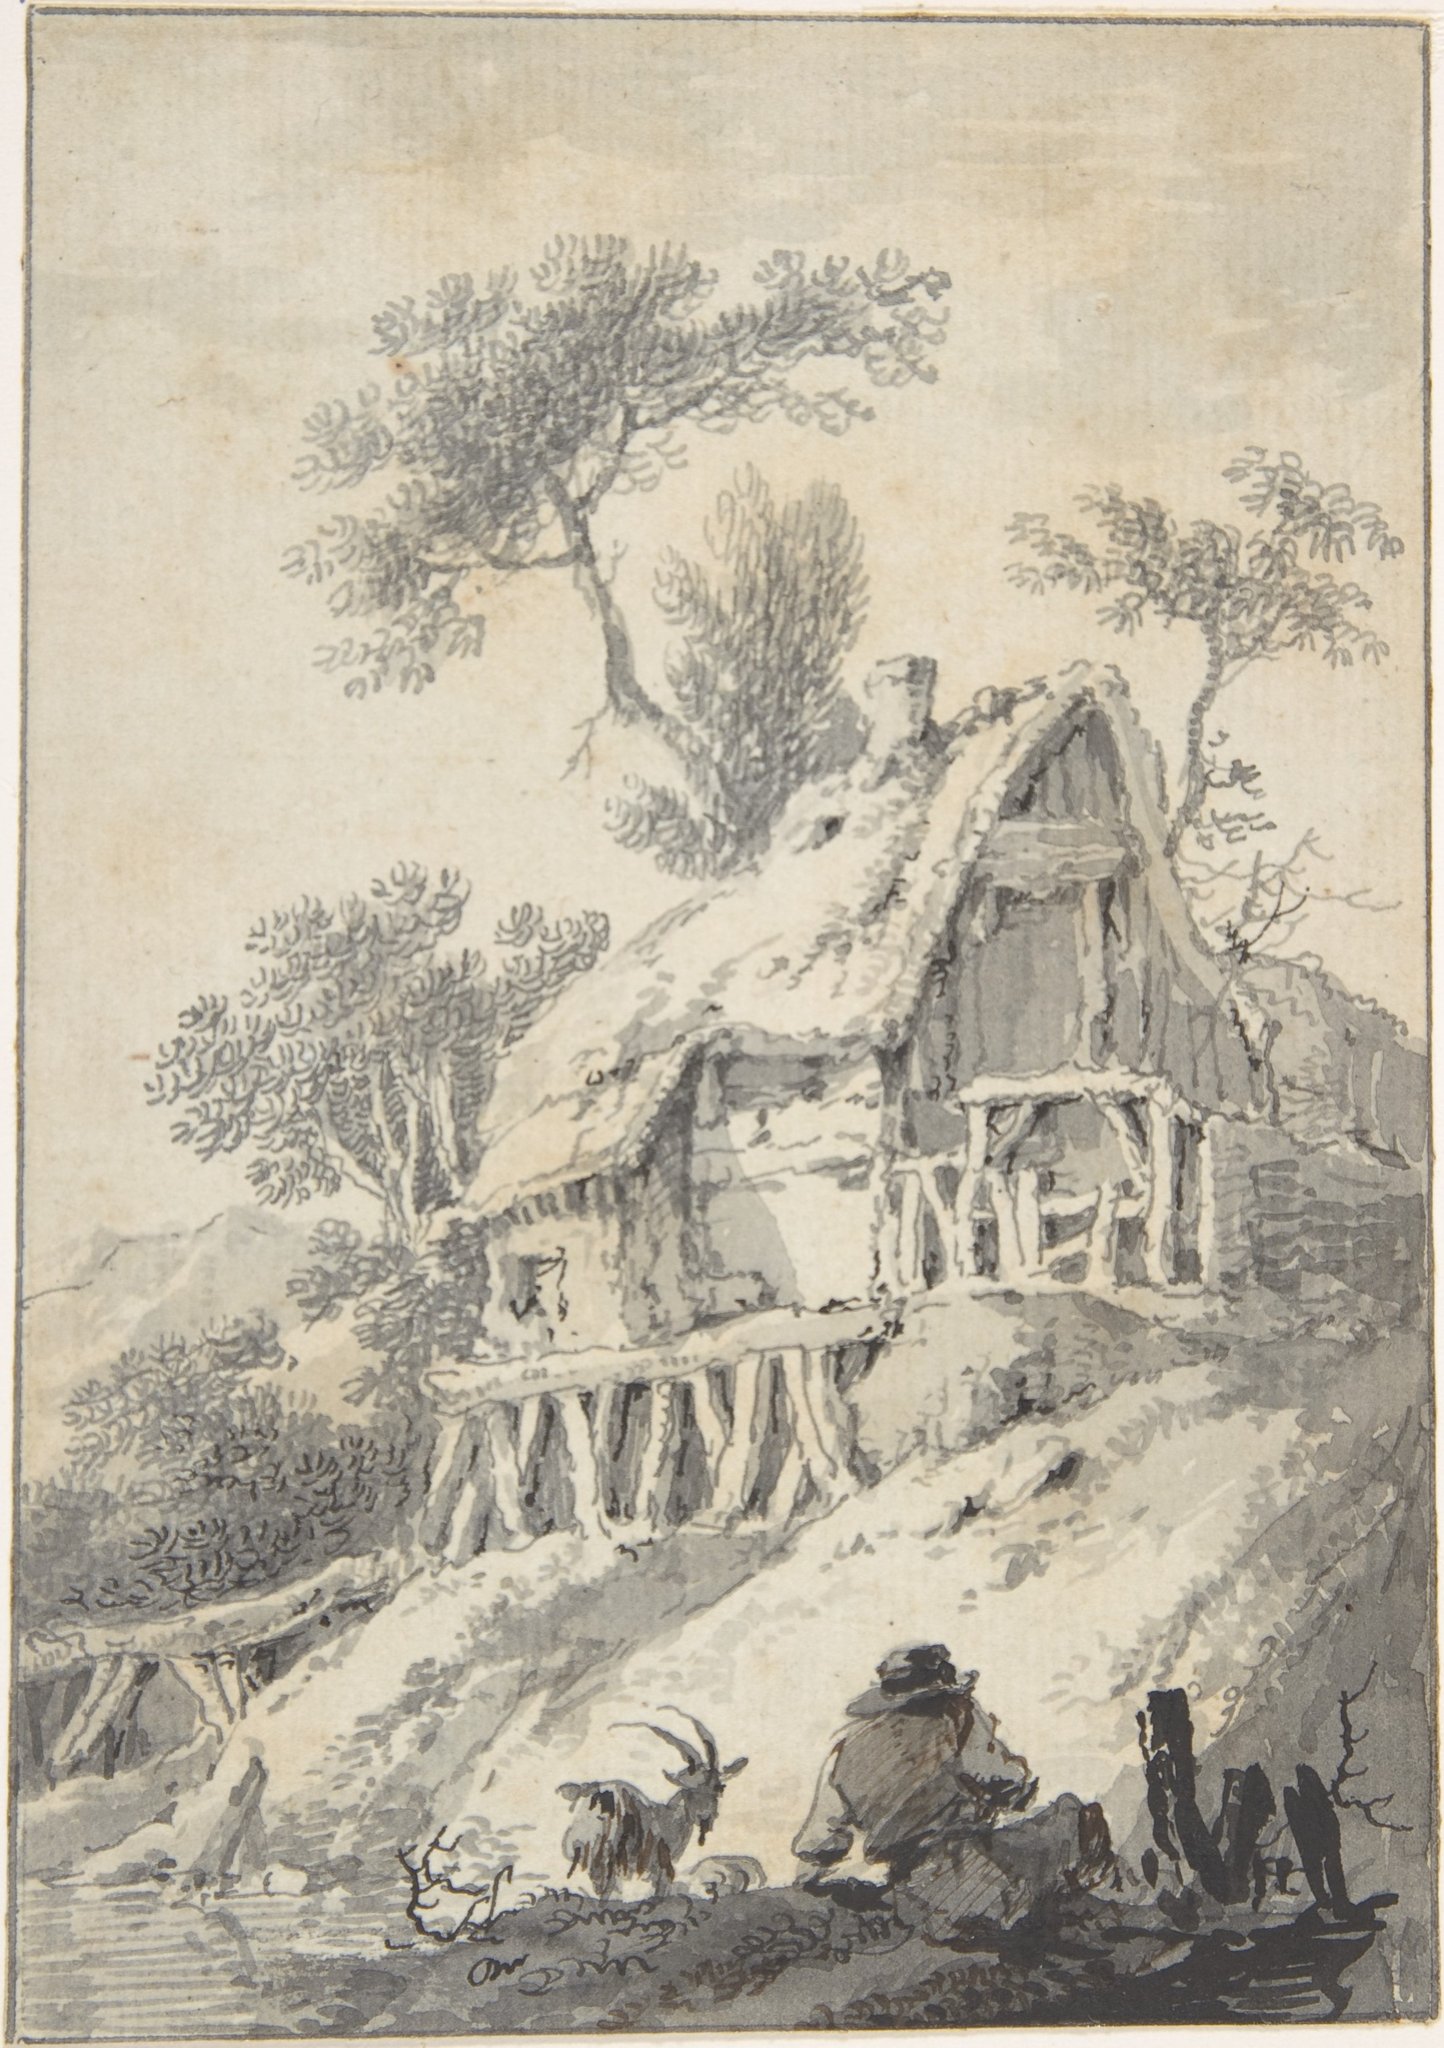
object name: drawing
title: Thatched Cottage by a Brook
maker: anonymous, dutch, 18th century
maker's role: artist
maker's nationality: dutch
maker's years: 1700-1800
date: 1701-1800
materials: ink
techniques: brush, pen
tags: animals,houses,men,trees